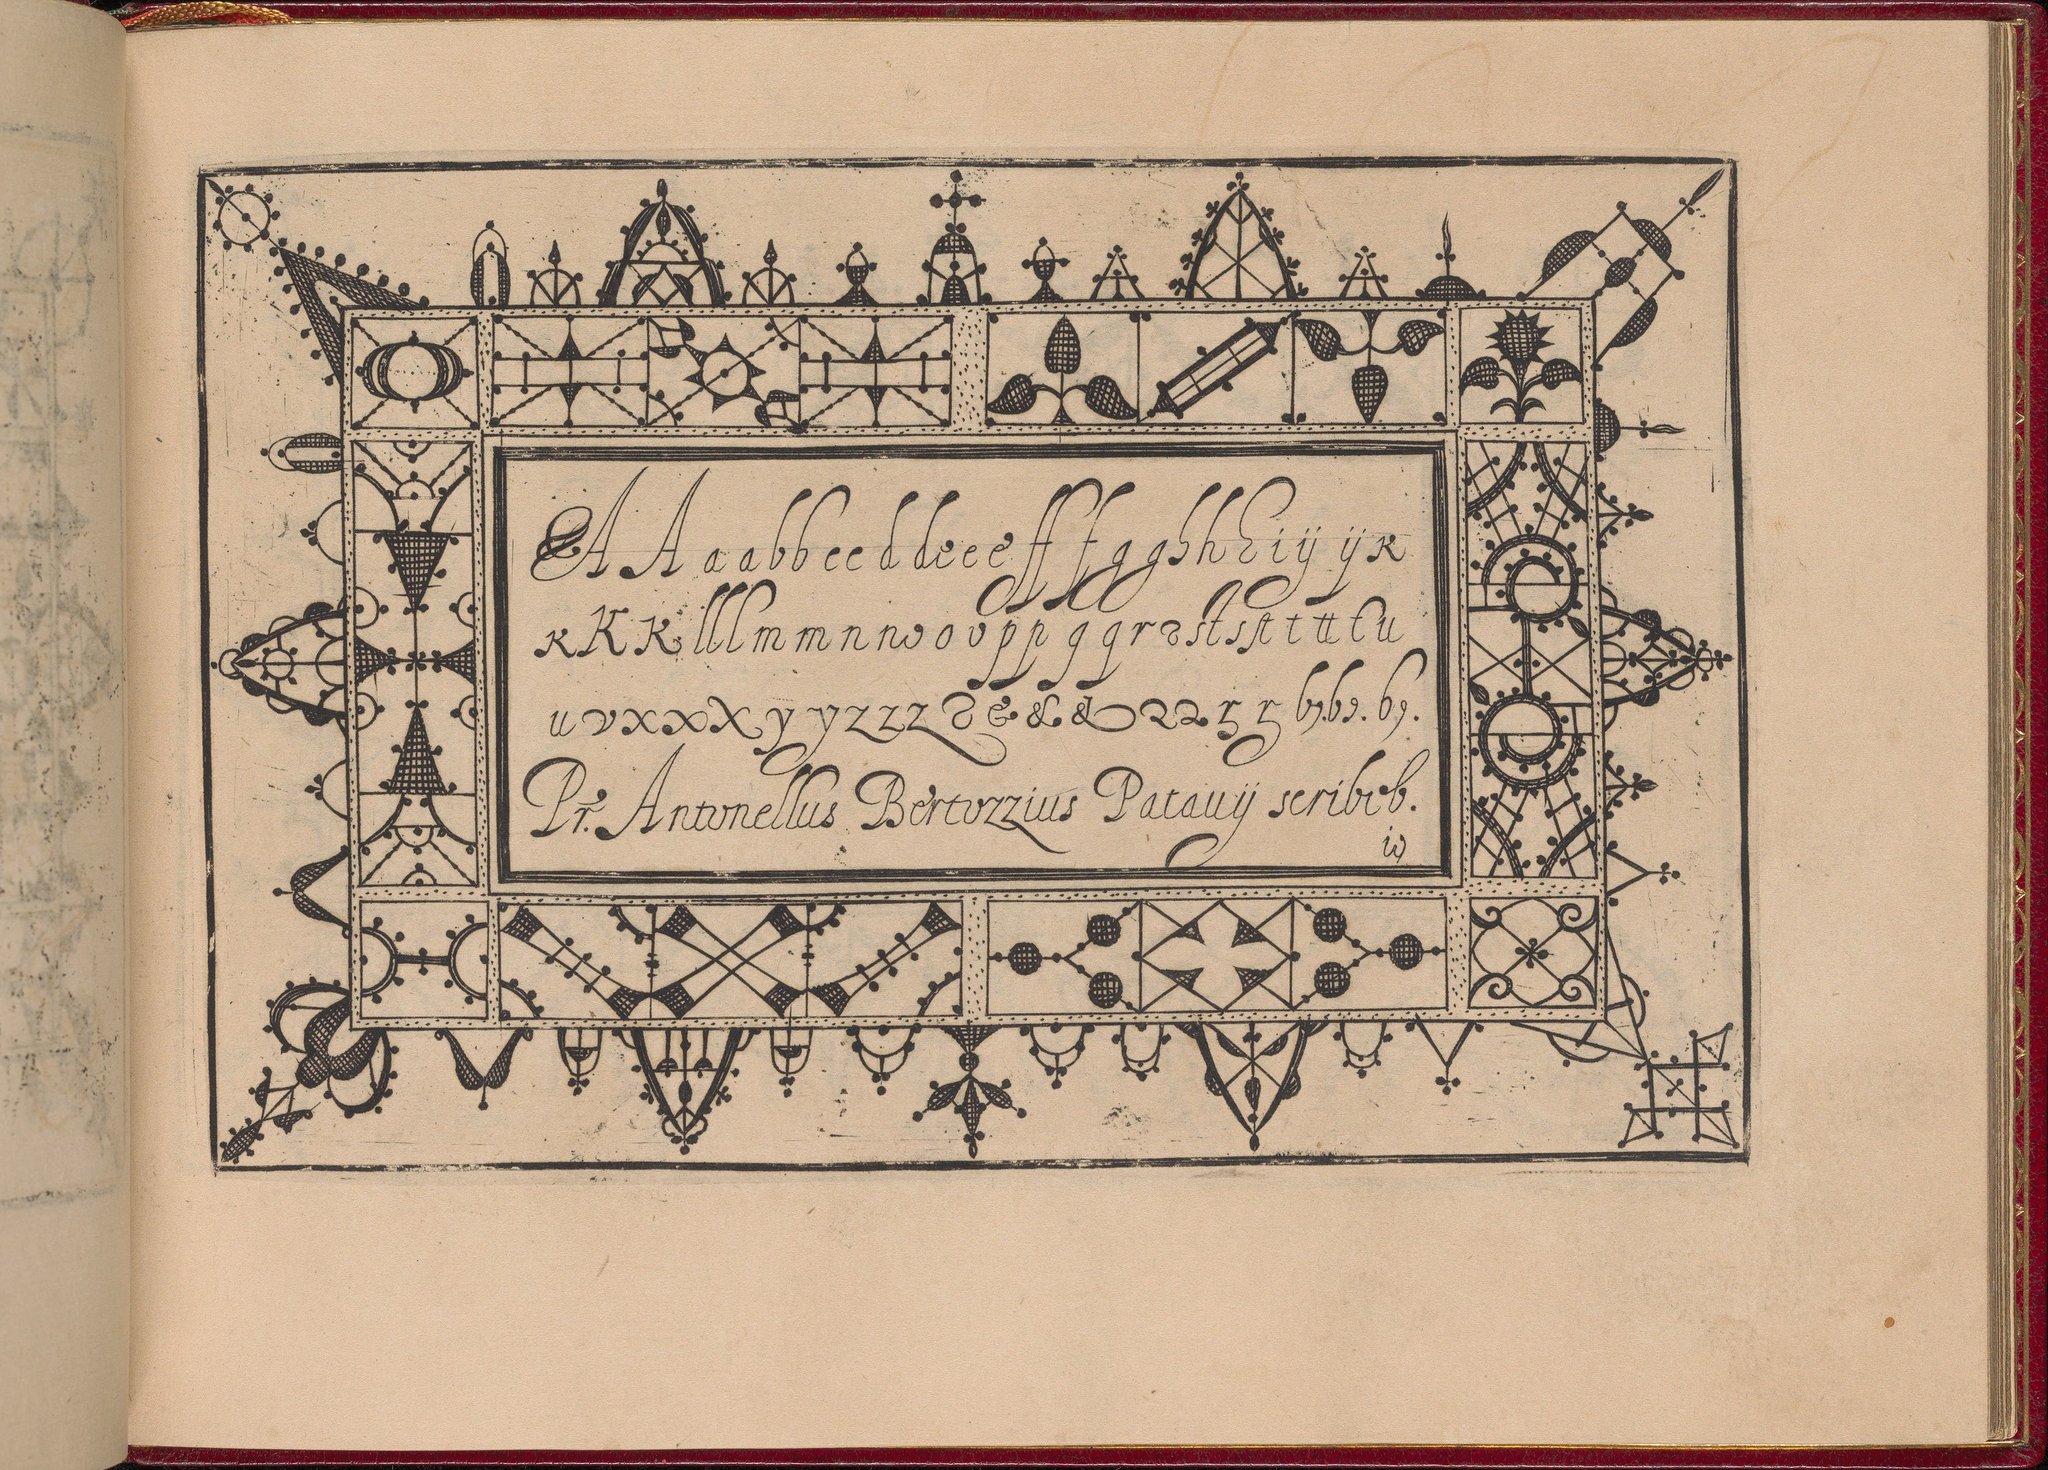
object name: book print ornament architecture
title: Ghirlanda: Di sei vaghi fiori scielti da piu famosi Giardini d'Italia, page 18 (recto)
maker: pietro paulo tozzi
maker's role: designer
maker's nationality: italian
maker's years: 1593-1628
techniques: drawing, etching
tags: ornament